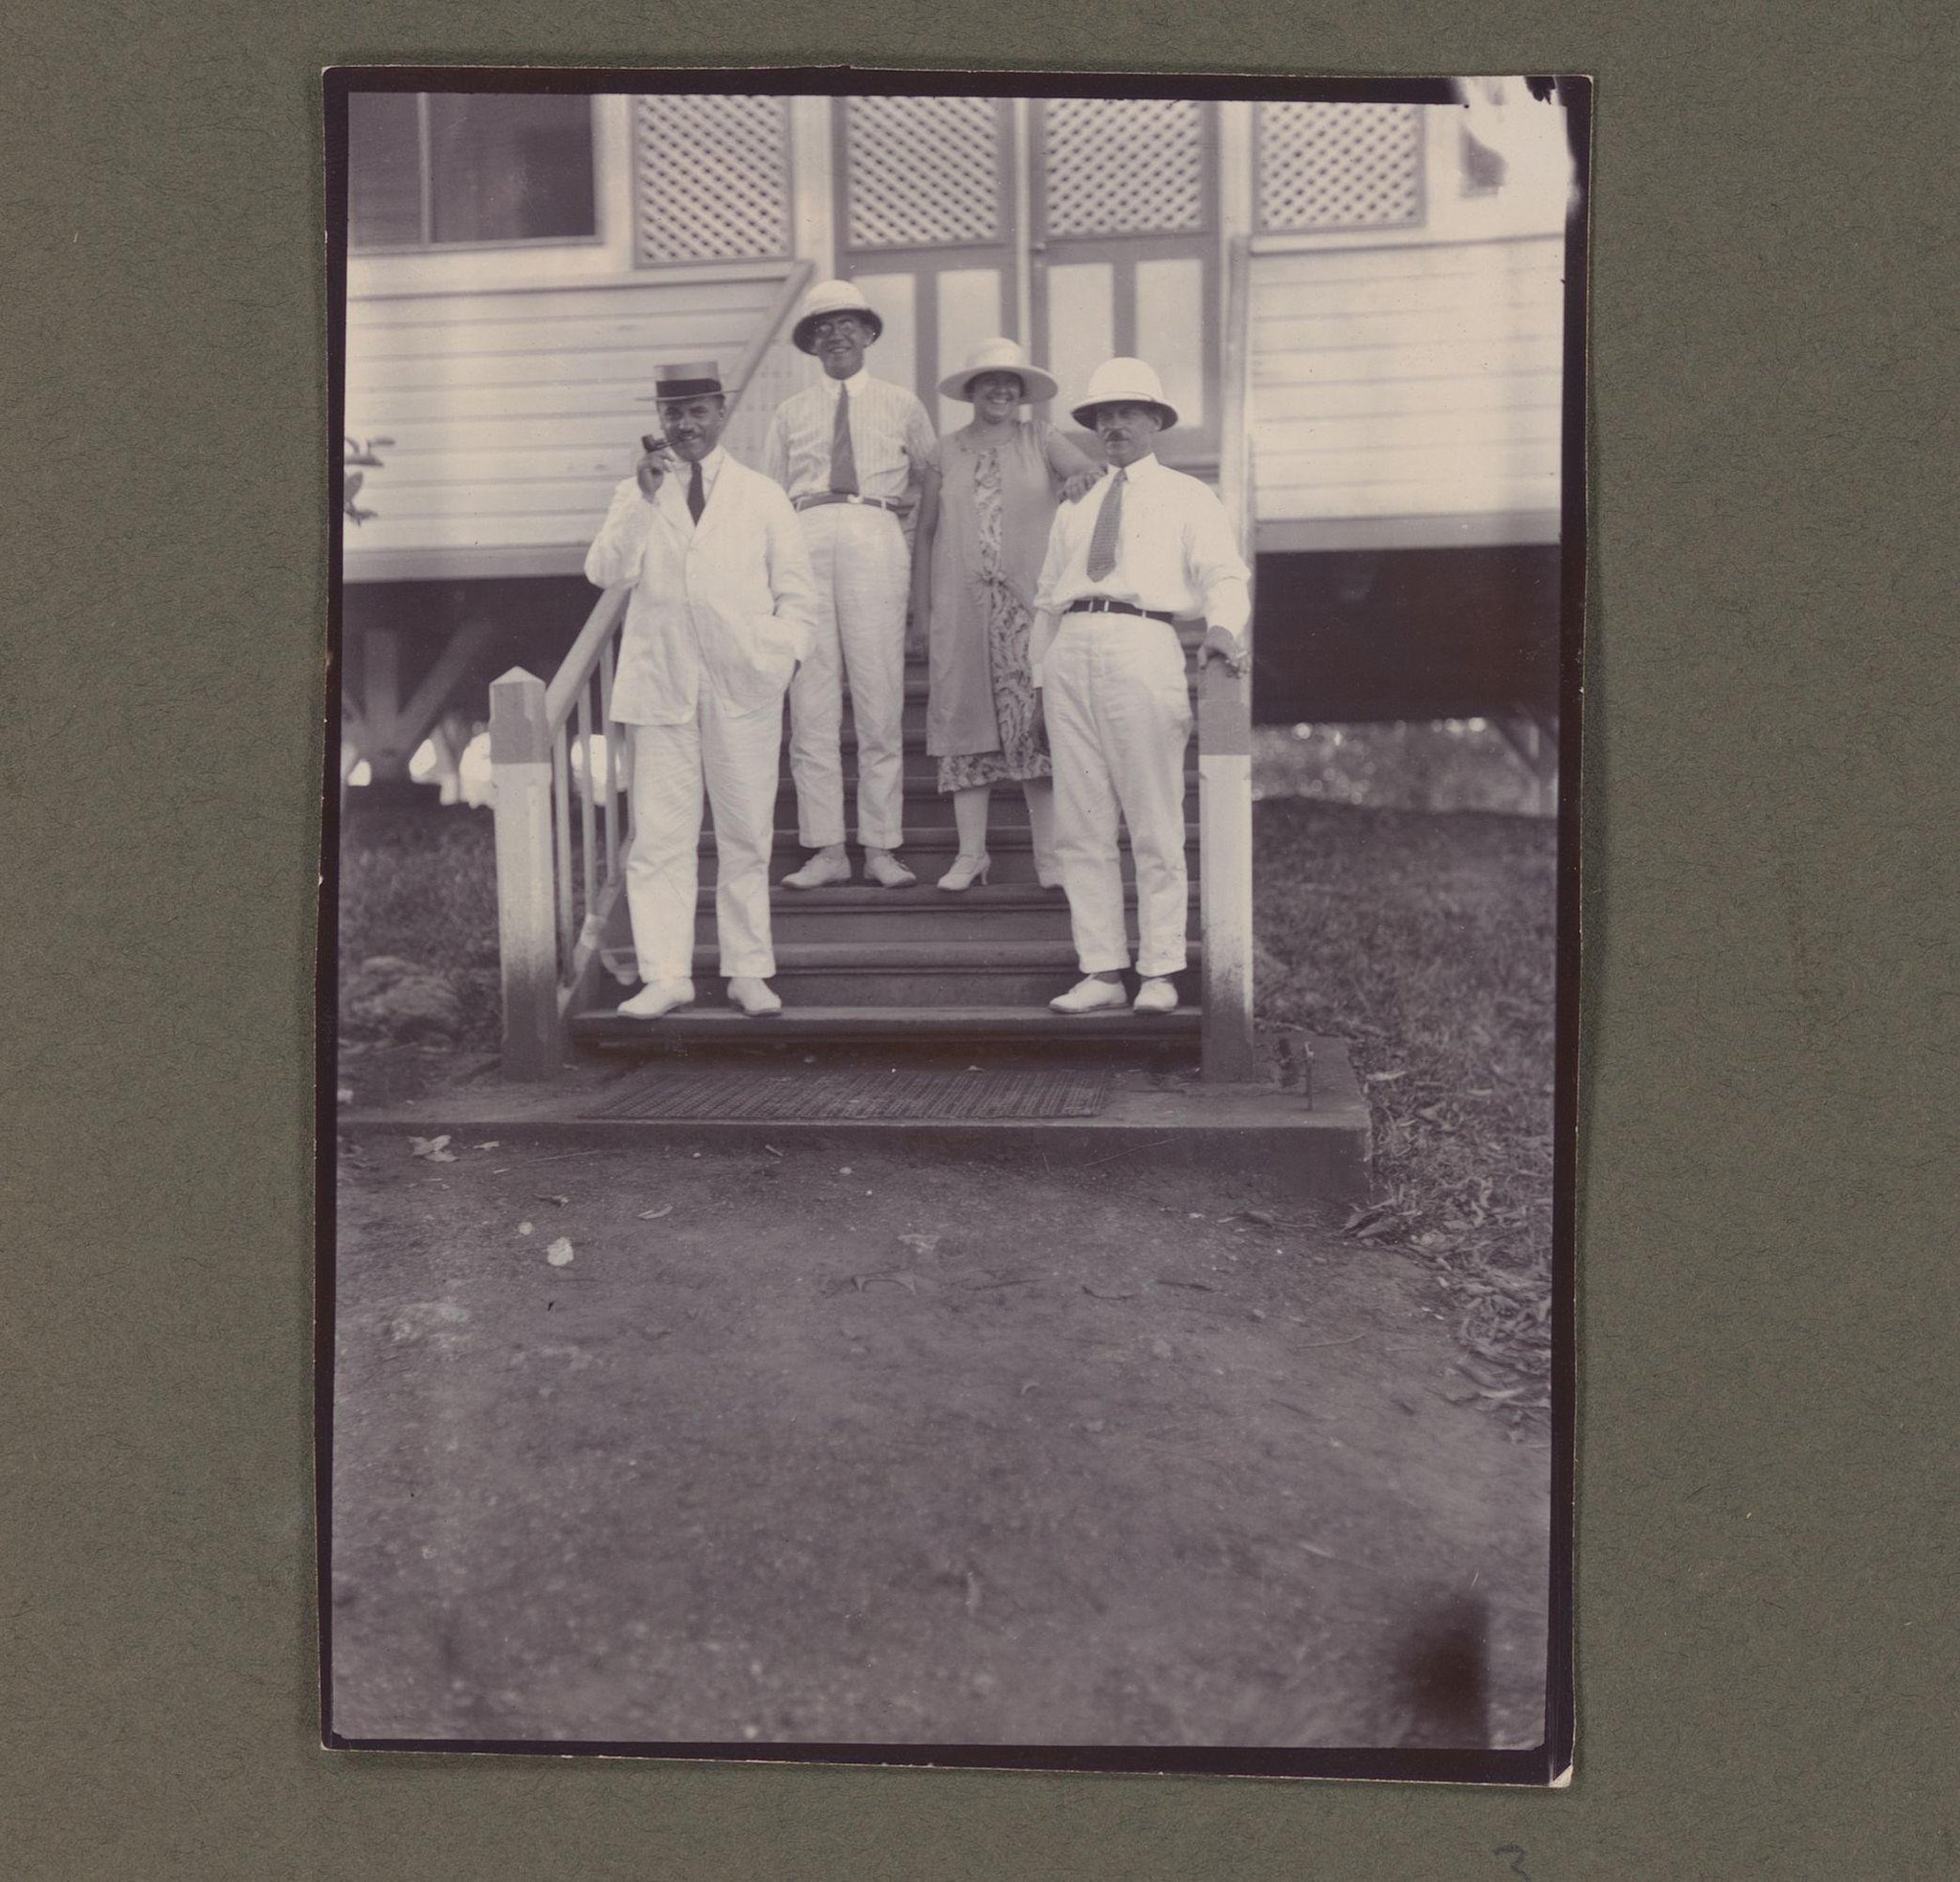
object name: photograph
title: Foto van drie mannen en een vrouw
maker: Anonymous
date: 1925-1927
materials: photographic support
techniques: photography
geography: suriname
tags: jetten, familie, moengo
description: Foto van een groep van drie mannen en een vrouw voor een huis te Moengo, linksboven R.A. Jetten. Foto op een bladzijde van een los albumblad. Onderdeel van het ensemble met foto's van de familie van ingenieur Jetten in de mijnbouwstad Moengo in Suriname.